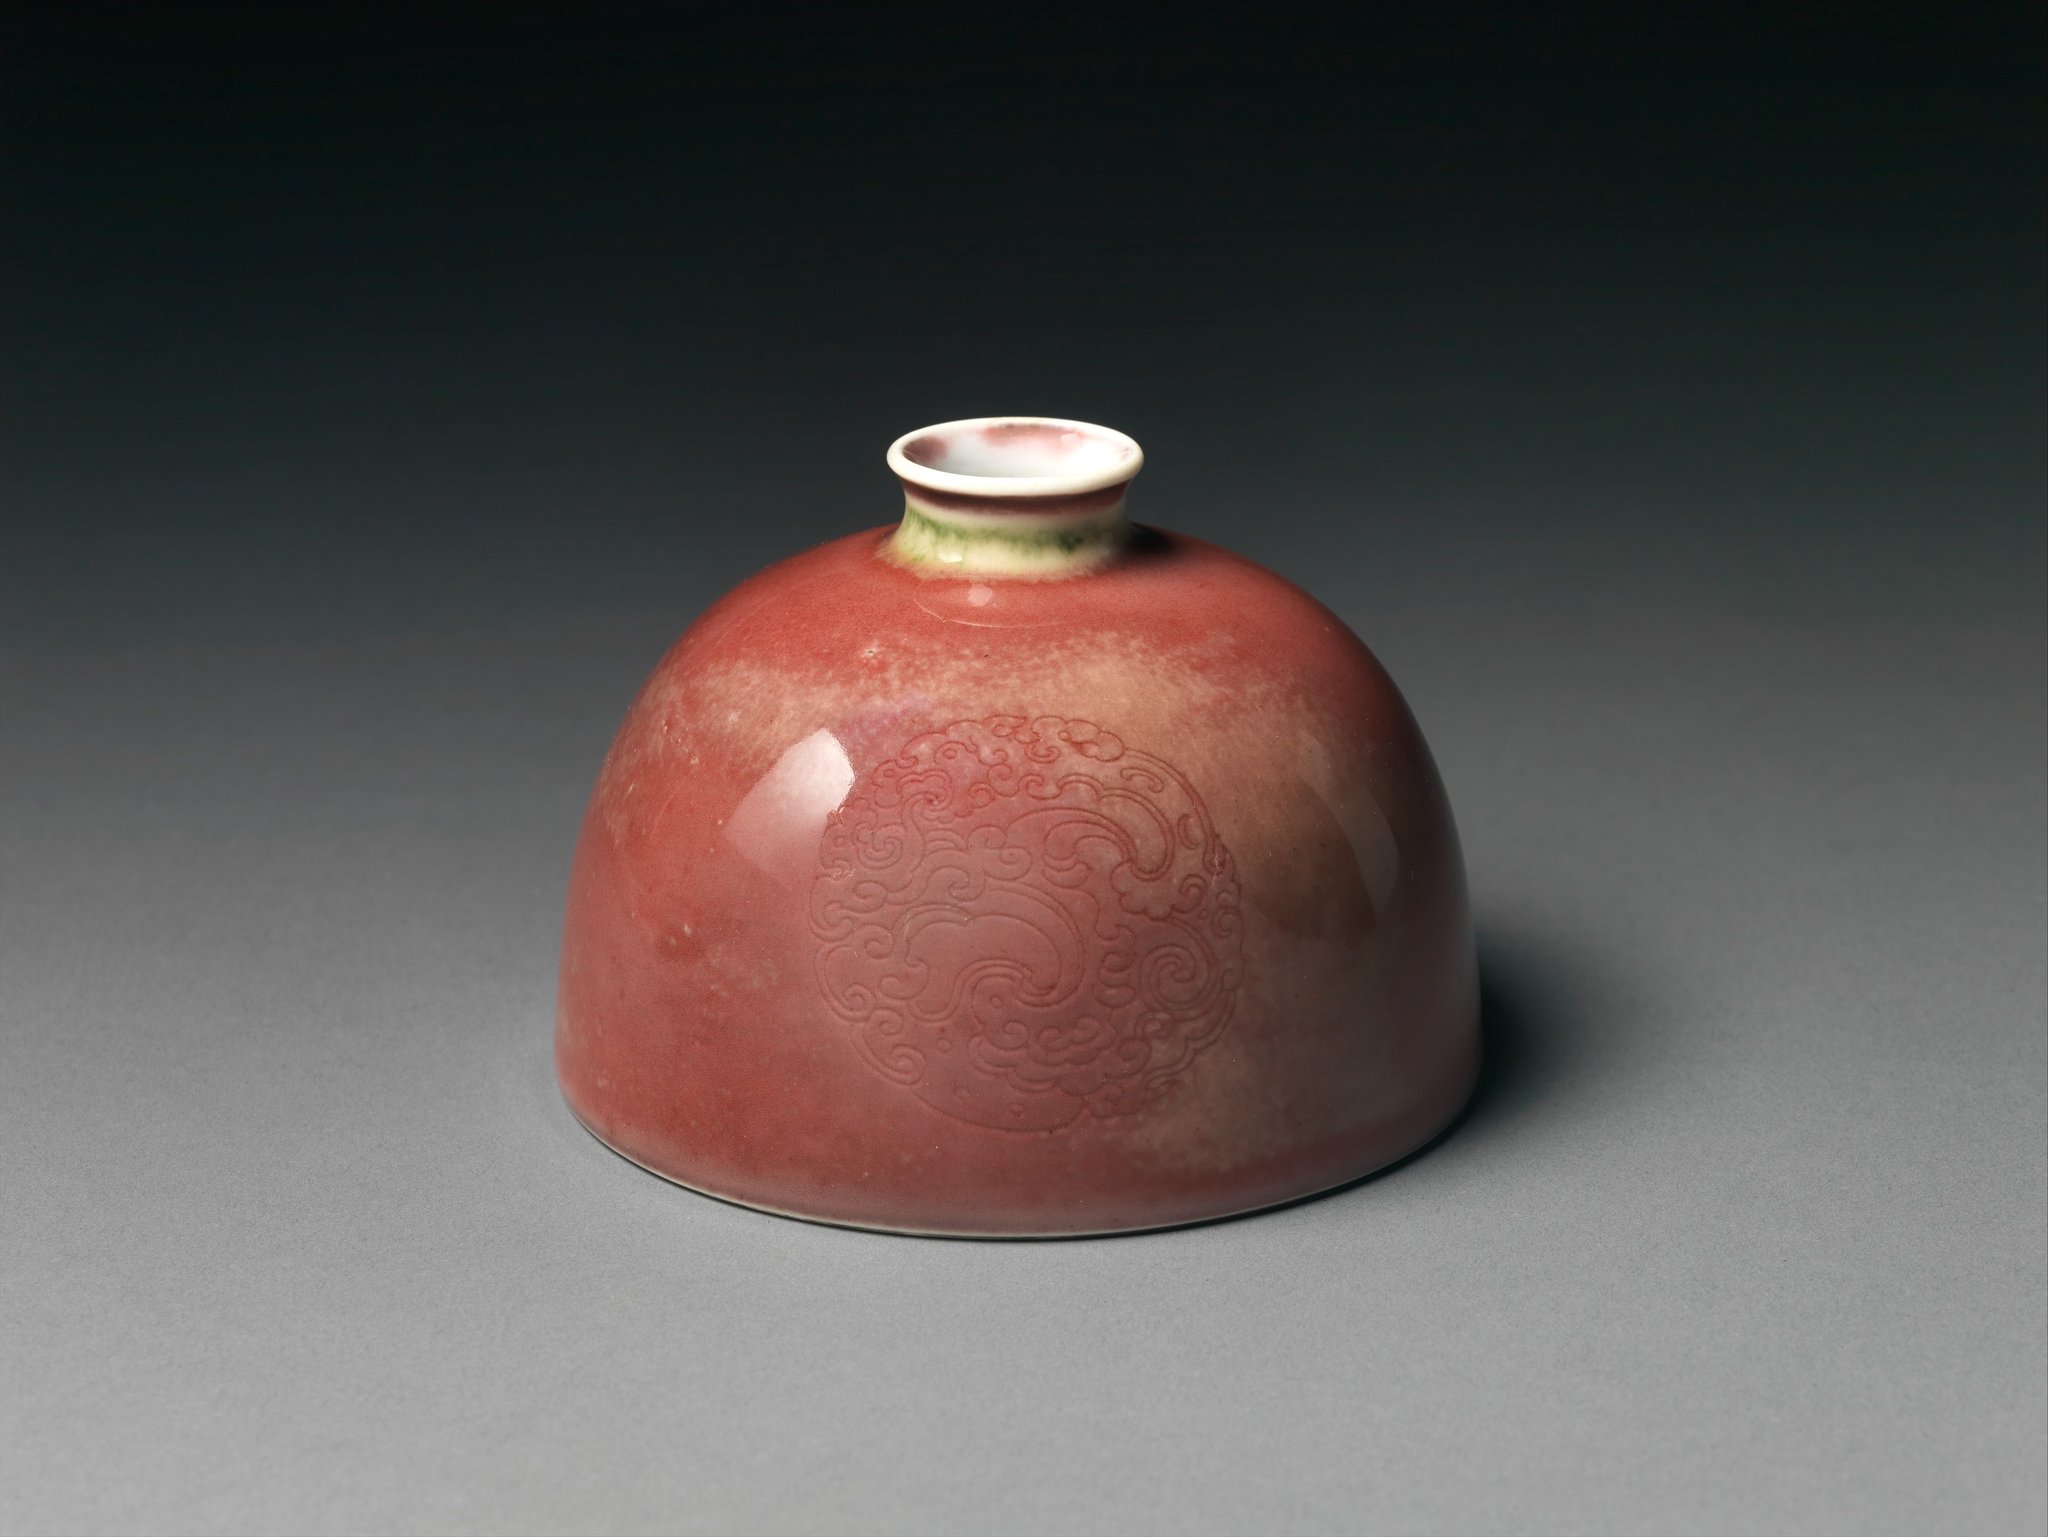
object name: water coupe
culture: chinese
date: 1700-1722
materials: glaze, porcelain